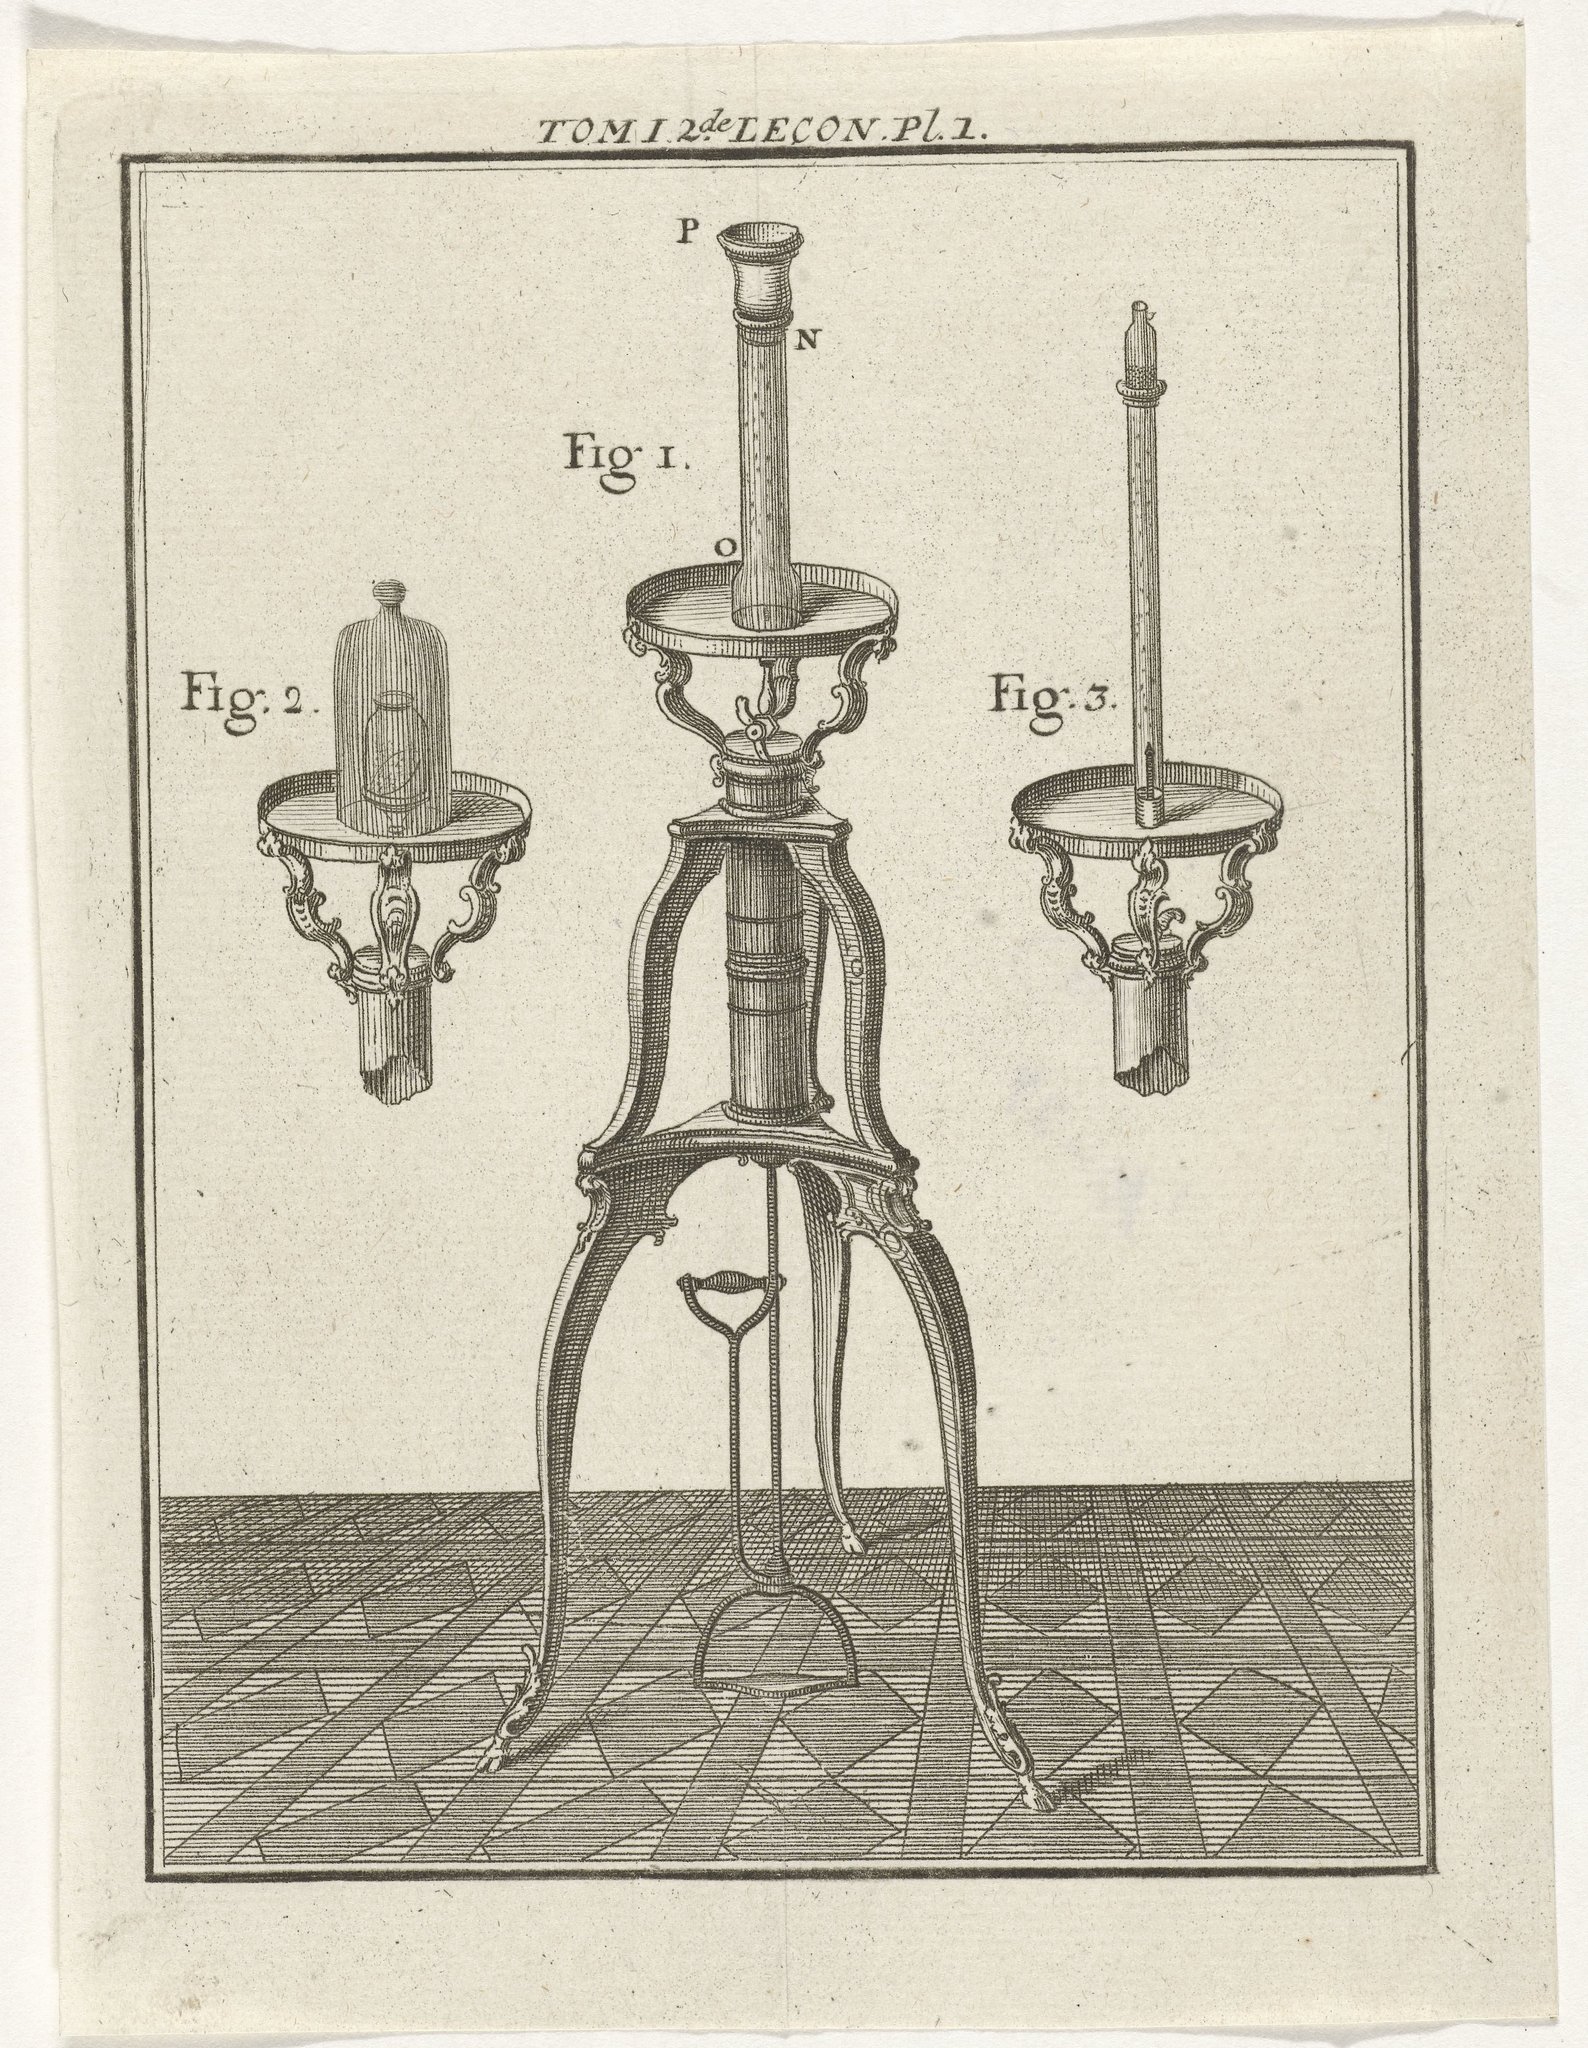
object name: book illustration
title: Natuurkundige instrumenten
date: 1759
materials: paper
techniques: etching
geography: amsterdam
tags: physics (+ tools, instruments; laboratory equipment ~ scientific research)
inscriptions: collector's mark: Lugt 2228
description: Illustratie voor: Nollet, Jean Antoine. Natuurkundige lessen, door proefneemingen bevestigd, eerste deel. Amsterdam: Kornelis van Tongerlo, 1759.